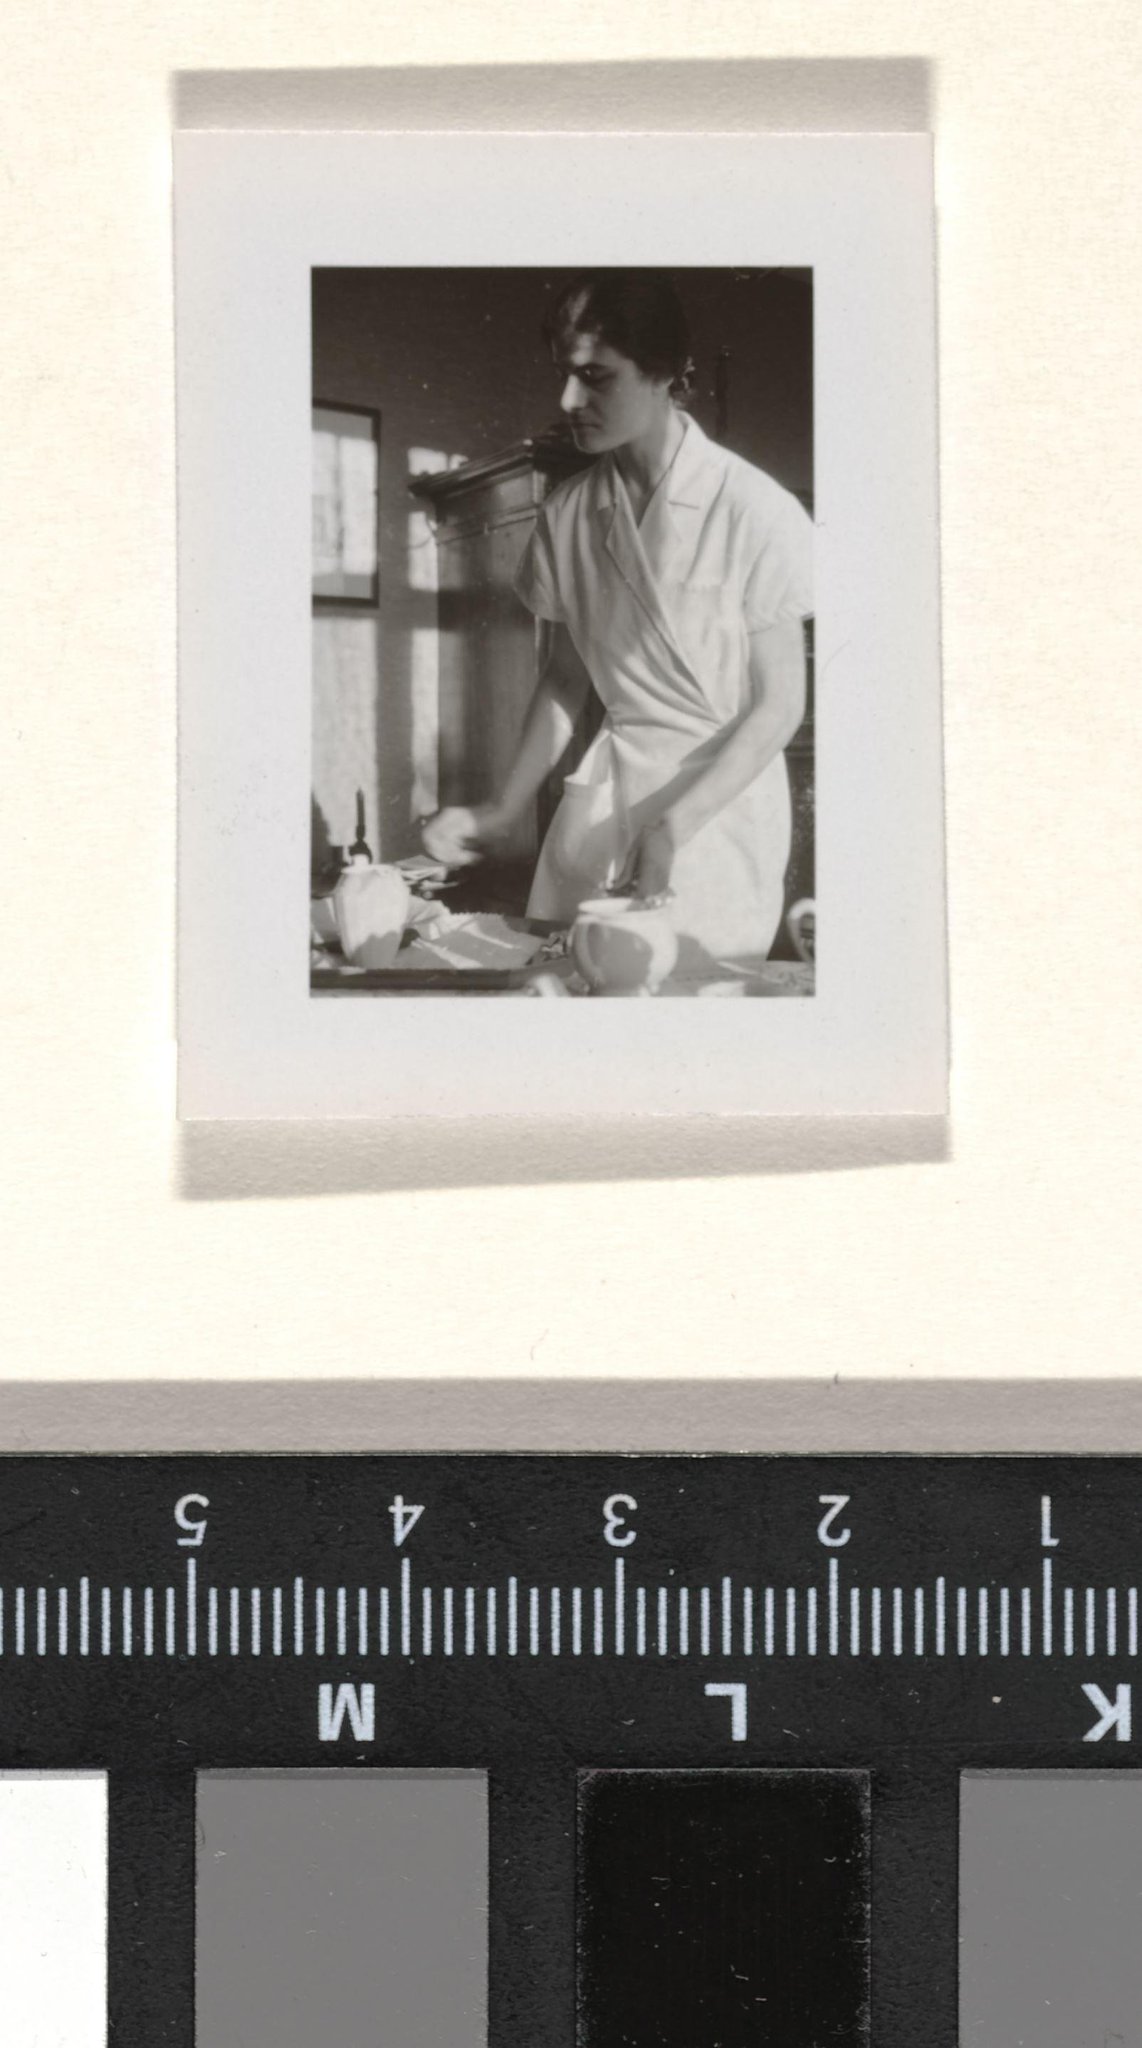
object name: photograph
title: Lid van de huishoudelijk staf van de familie Wachenheimer, mogelijk het kindermeisje, staande bij een tafel met twee theepotten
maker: Anonymous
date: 1928-1937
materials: photographic support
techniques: gelatin silver print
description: Onbekend lid van de huishoudelijk staf van de familie Wachenheimer, mogelijk het kindermeisje, staande bij een tafel met twee theepotten.